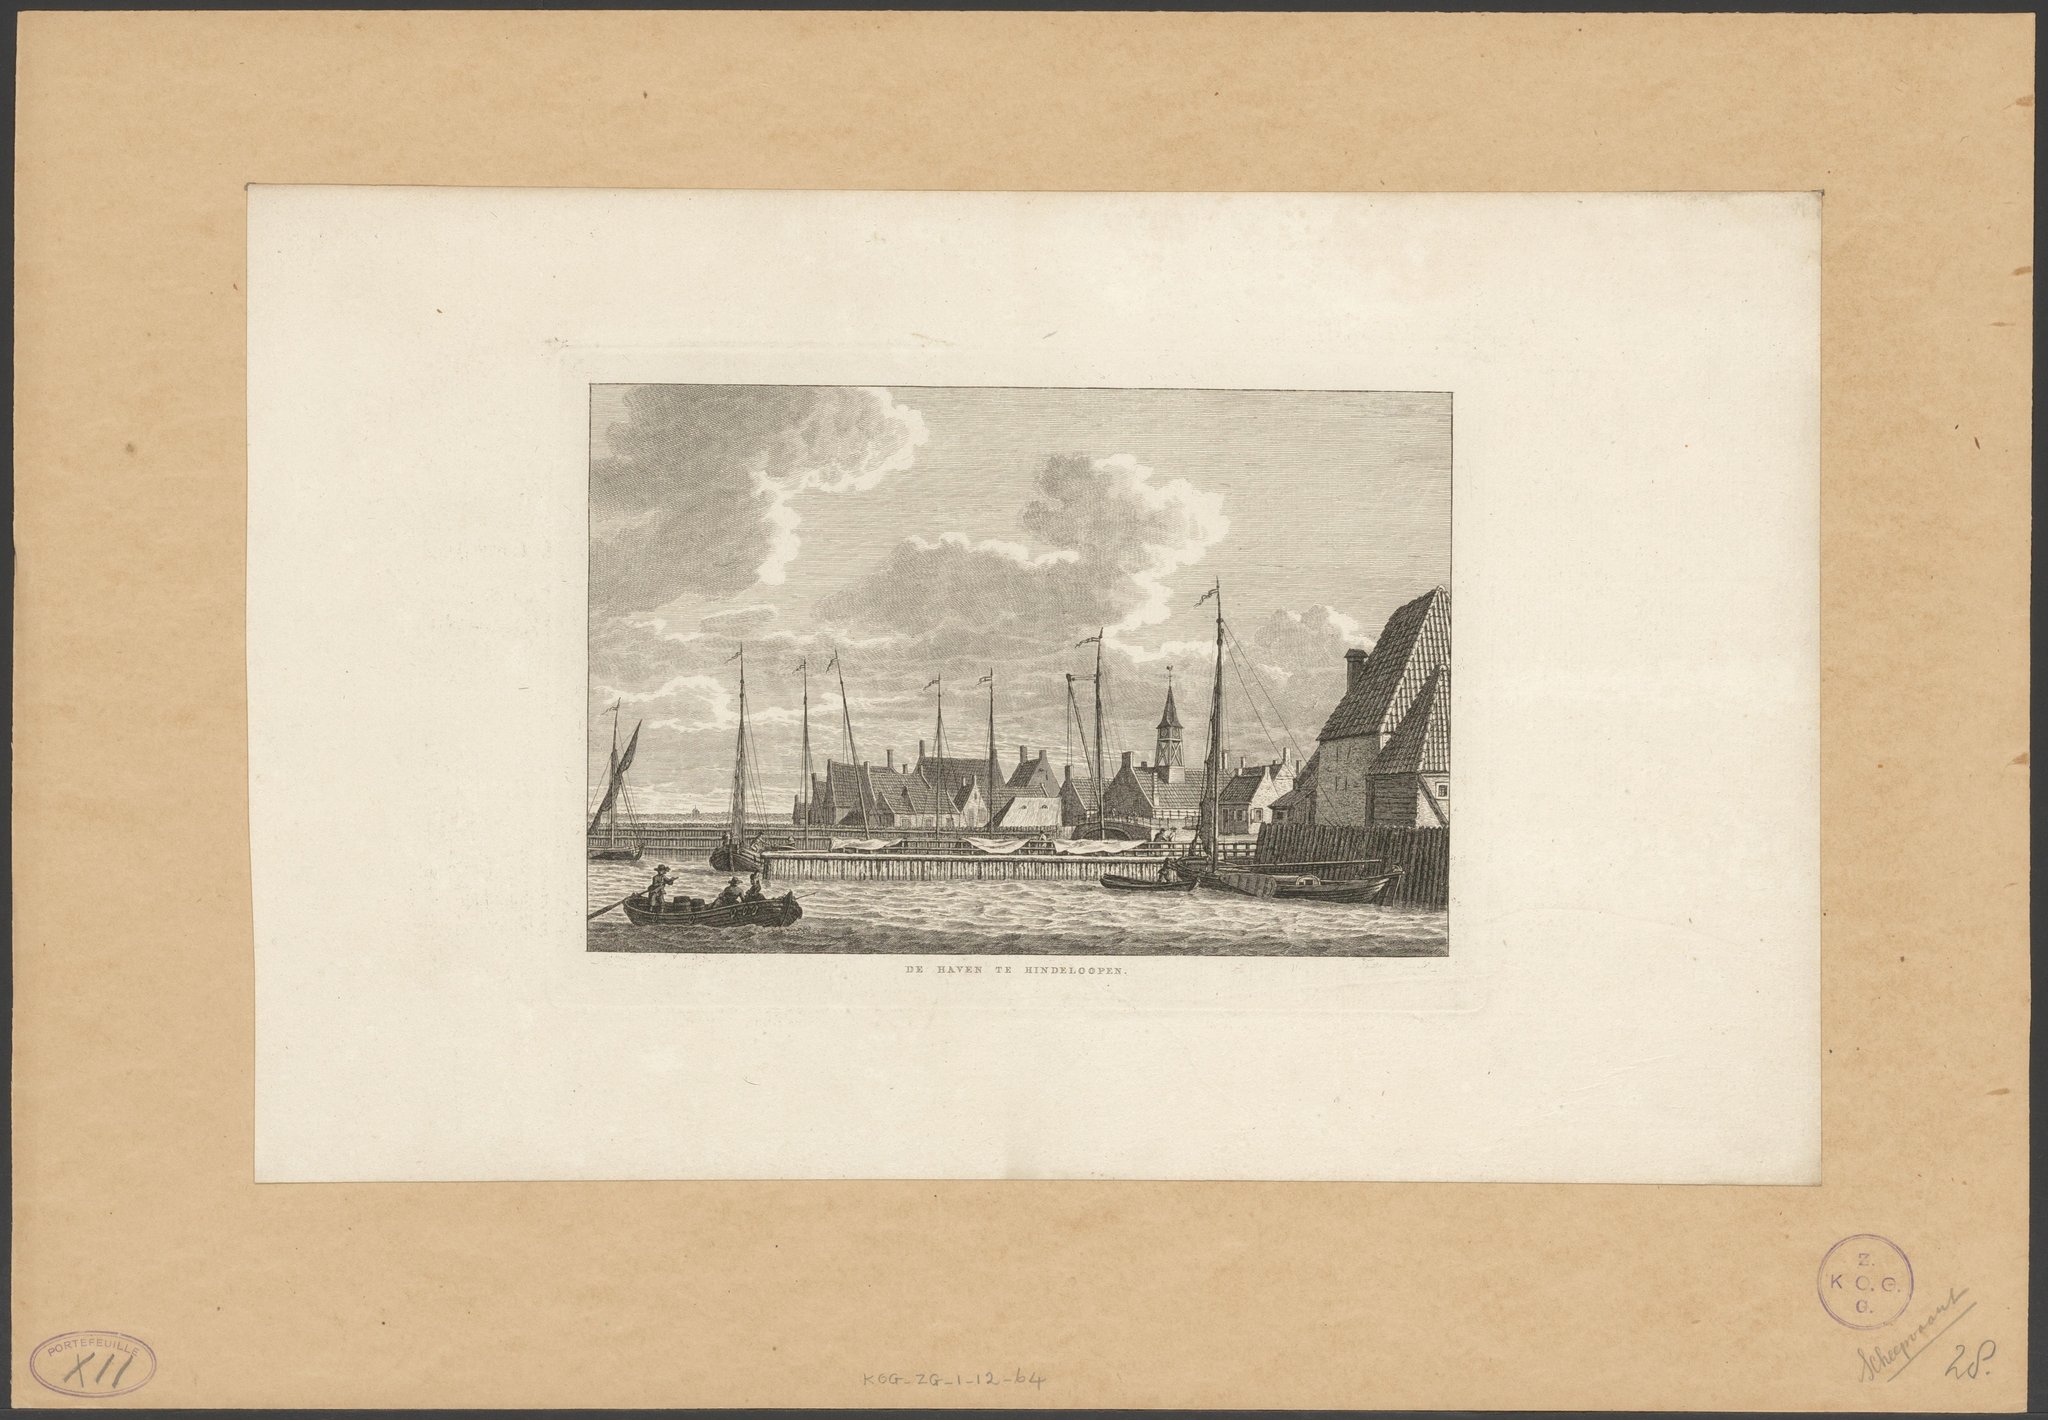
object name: book illustration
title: De haven van Hindeloopen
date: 1786-1792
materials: paper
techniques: etching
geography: amsterdam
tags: city-view, and landscape with man-made constructions, sailing-ship, sailing-boat, rowing-boat, canoe, etc.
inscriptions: collector's mark: Lugt 1641, stamp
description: Prent uit: Vaderlandsche gezichten, of afbeeldingen van den tegenwoordigen staat der Vereenigde Nederlanden (…). Amsterdam: Hendrik Gartman, Willem Vermandel en Jan Willem Smit, 1786-1792. Uitgegeven in afleveringen met ieder een eigen bifolium en inhoudsopgave. Alle prenten in deze publicatie zijn gegraveerd door Carel Frederik Bendorp (I) en, in de meeste gevallen, gebaseerd op tekeningen van Jan Bulthuis.